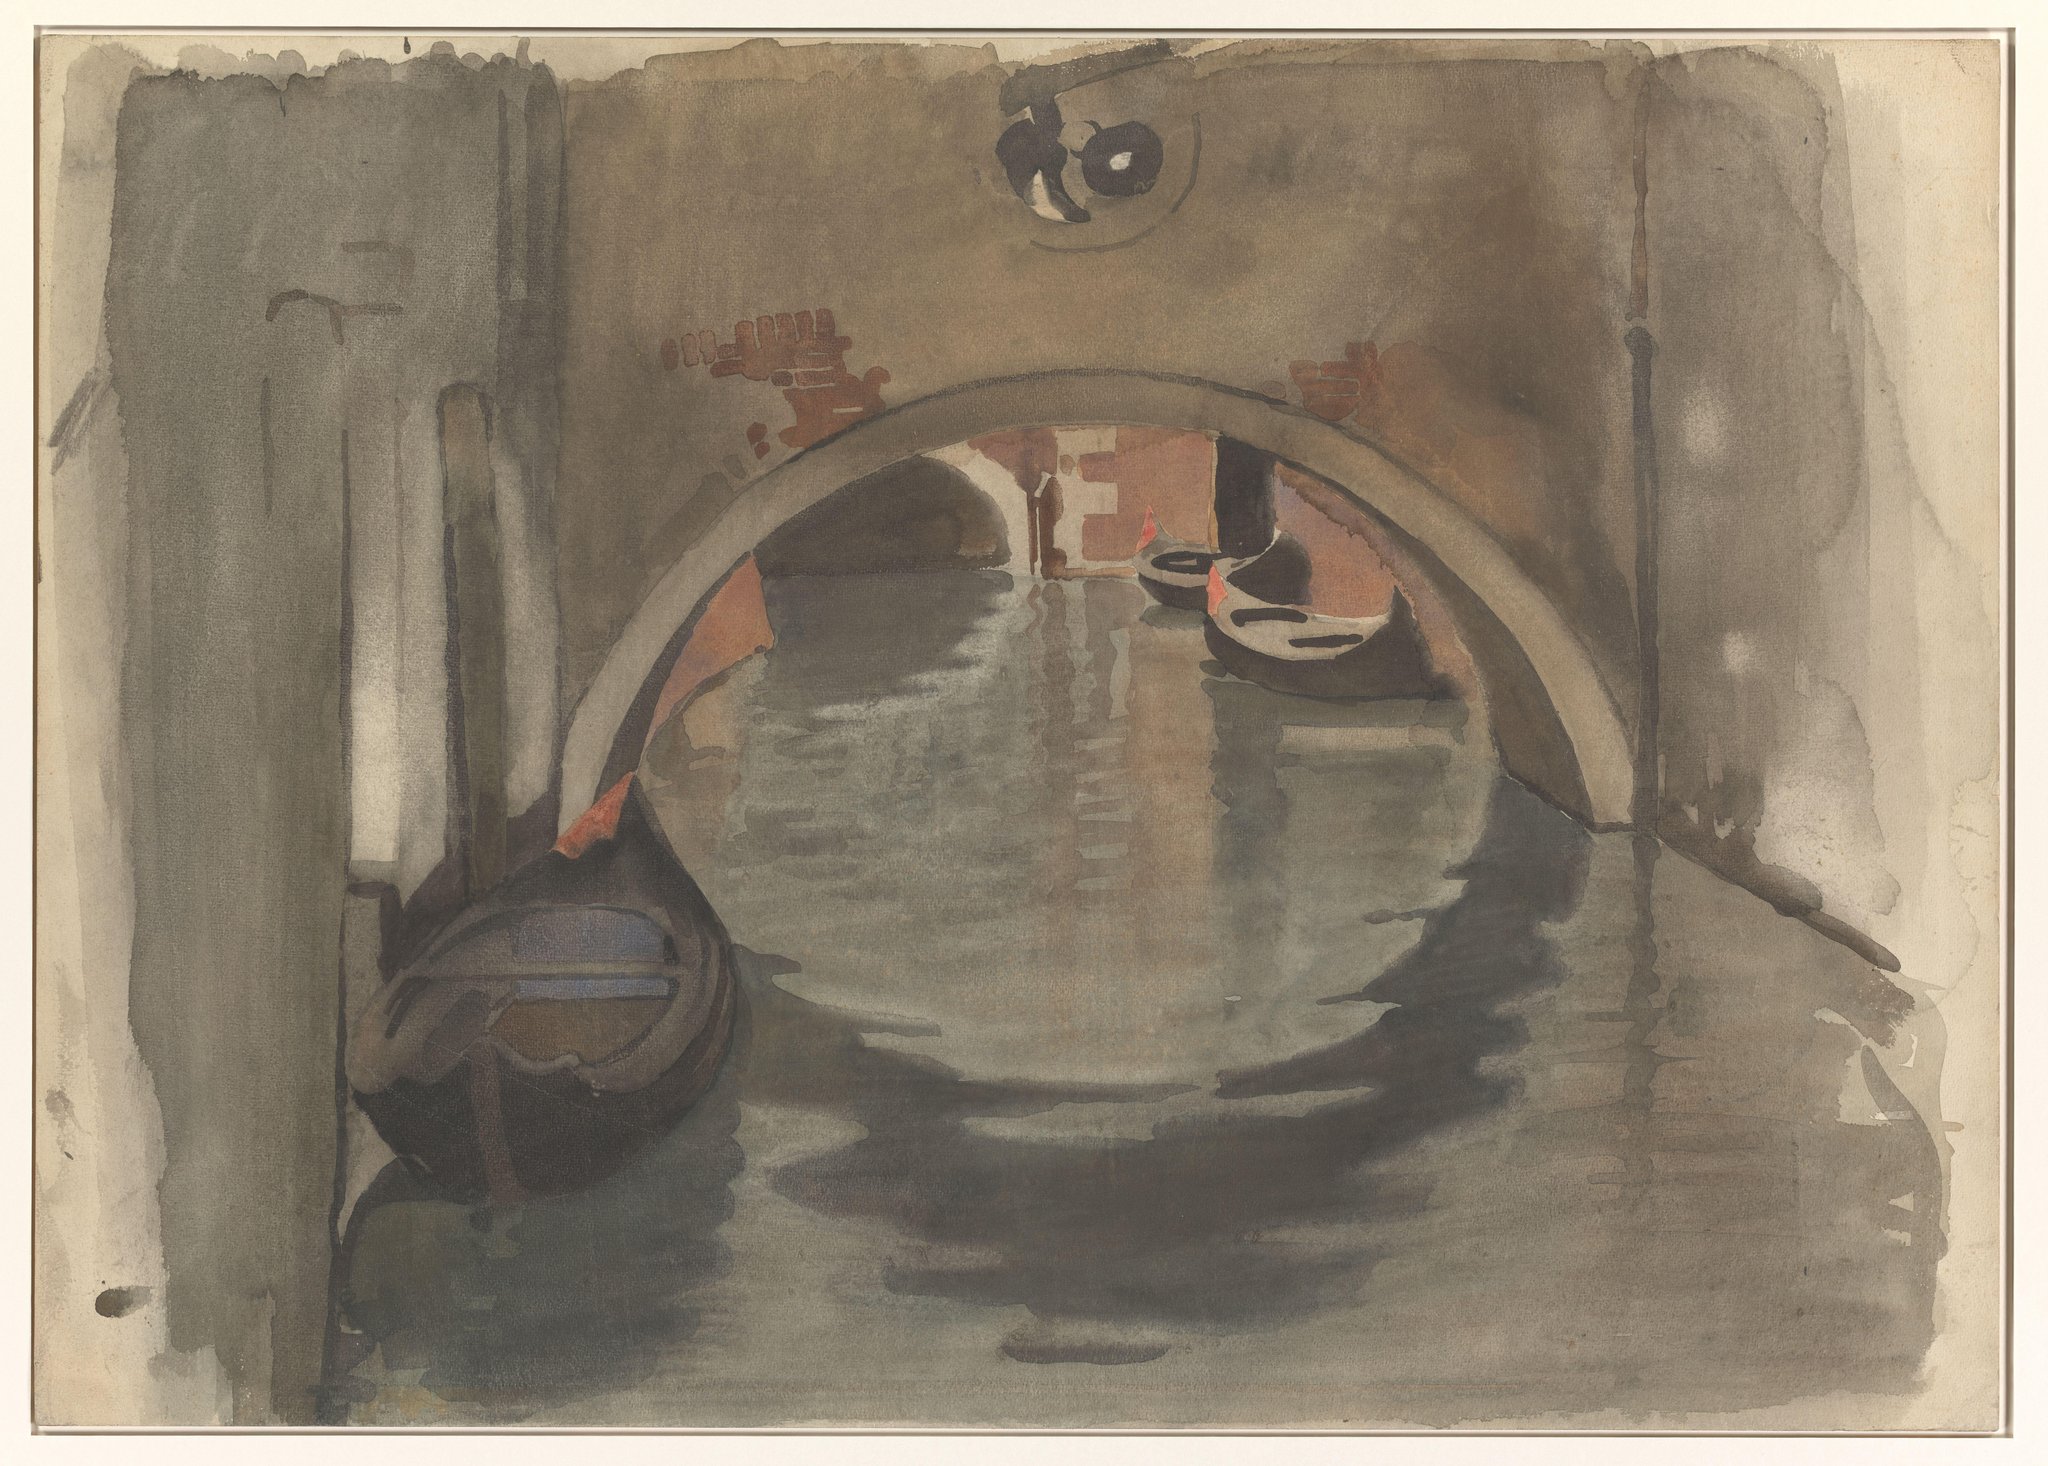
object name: drawing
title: Gezicht onder een boogbrug te Venetië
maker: willem witsen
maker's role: draughtsman, painter, print maker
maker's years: 1860-1923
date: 1870-1923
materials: cardboard, watercolor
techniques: brush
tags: landscape with bridge, viaduct or aqueduct, canals, waters (in city), italy, venice